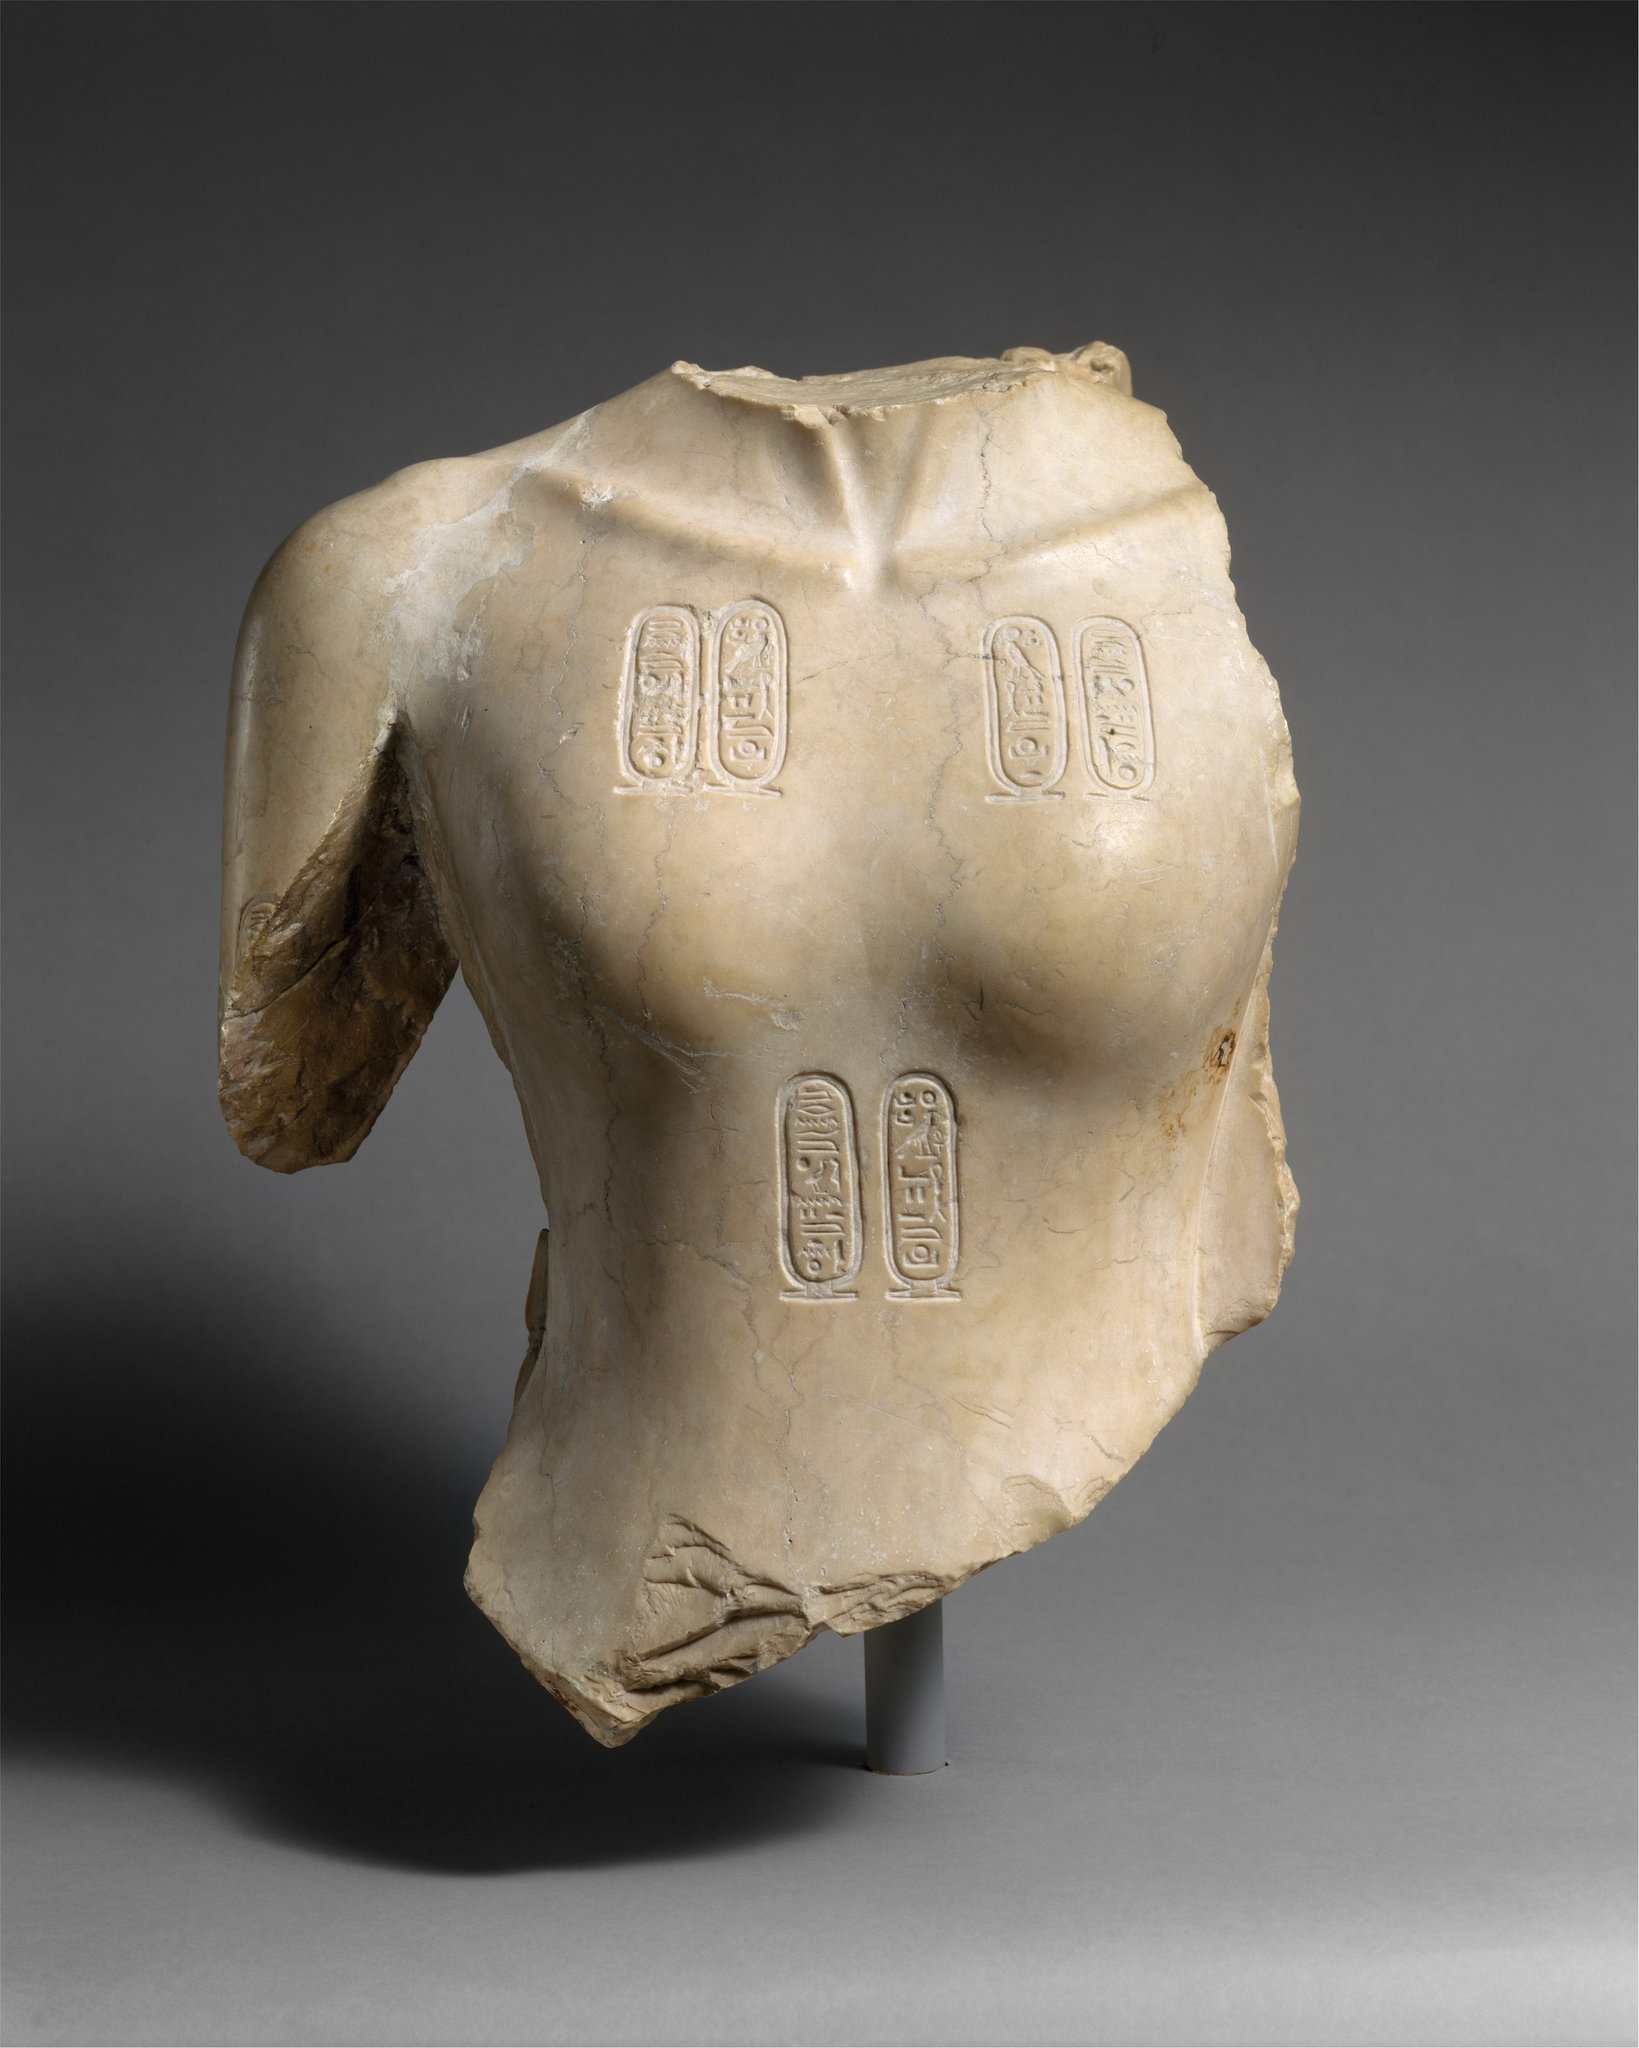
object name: akhenaten torso, aten cartouch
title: Torso of Akhenaten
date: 1353-1336 BCE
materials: limestone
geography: egypt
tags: men,hieroglyphs